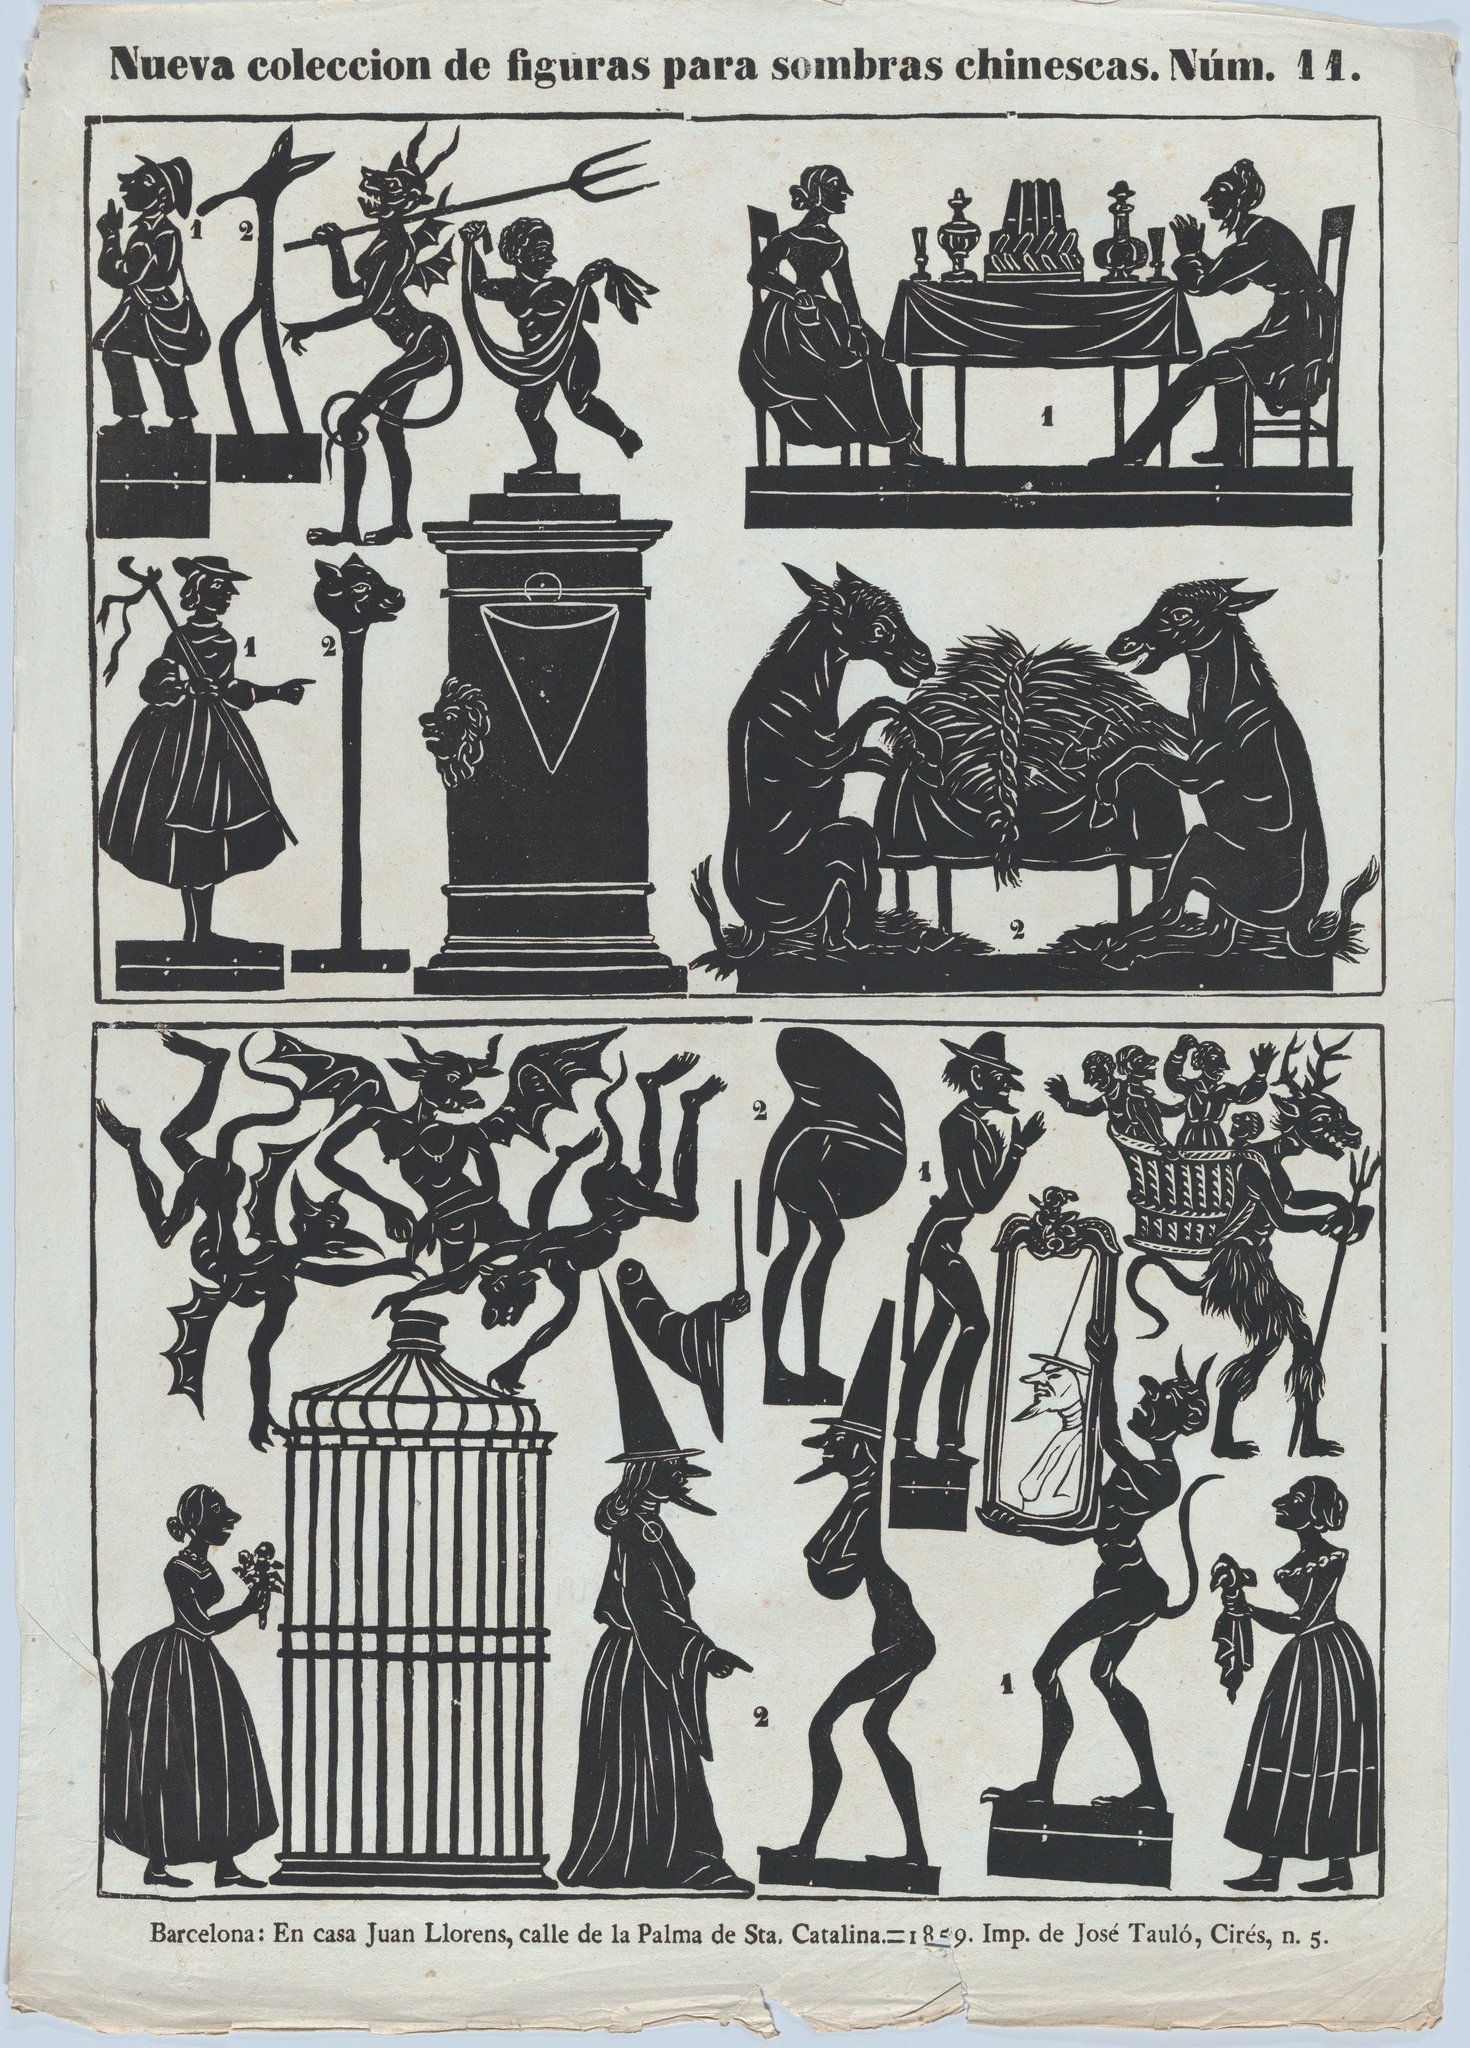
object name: print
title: Sheet 11 of figures for Chinese shadow puppets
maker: juan llorens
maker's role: publisher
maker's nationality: spanish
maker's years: 1800-1900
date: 1859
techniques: engraving, woodcut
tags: animals,women,devil,puppets